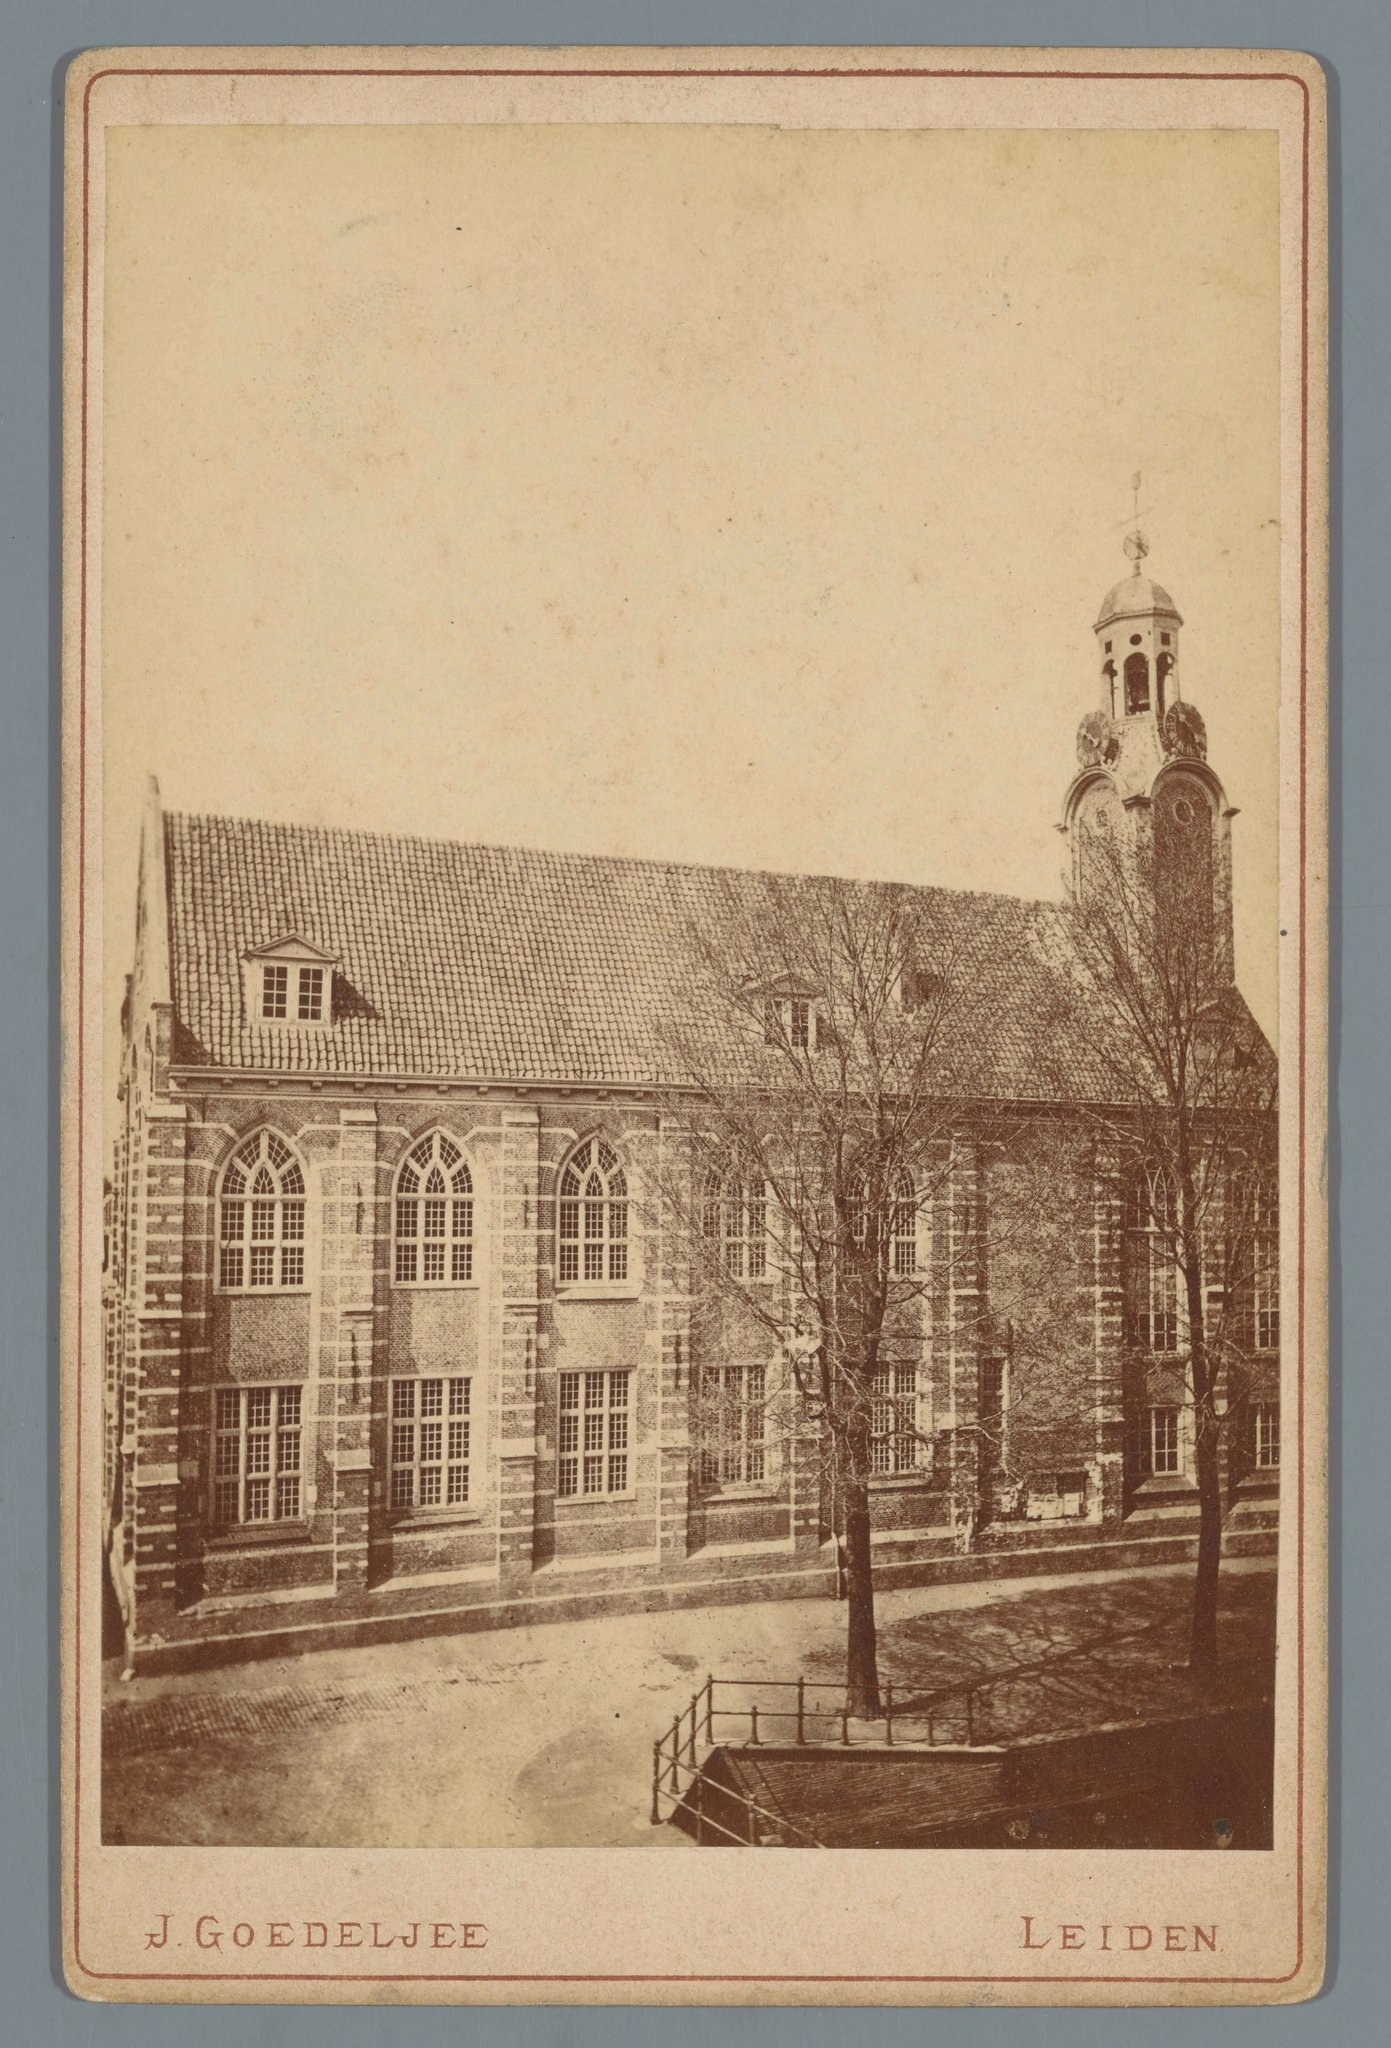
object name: photograph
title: Gezicht op het Academiegebouw aan het Rapenburg te Leiden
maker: jan goedeljee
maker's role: fotograaf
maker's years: 1824-1905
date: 1850-1900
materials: cardboard, photographic support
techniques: albumen print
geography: leiden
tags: university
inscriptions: retailer's mark: ‘(...)INTERNATIONALE/ TENTOONSTELLING TE UTRECHT/ 1876./ J. GOEDELJEE/ HOOGEWORD 160./ LEIDEN.’